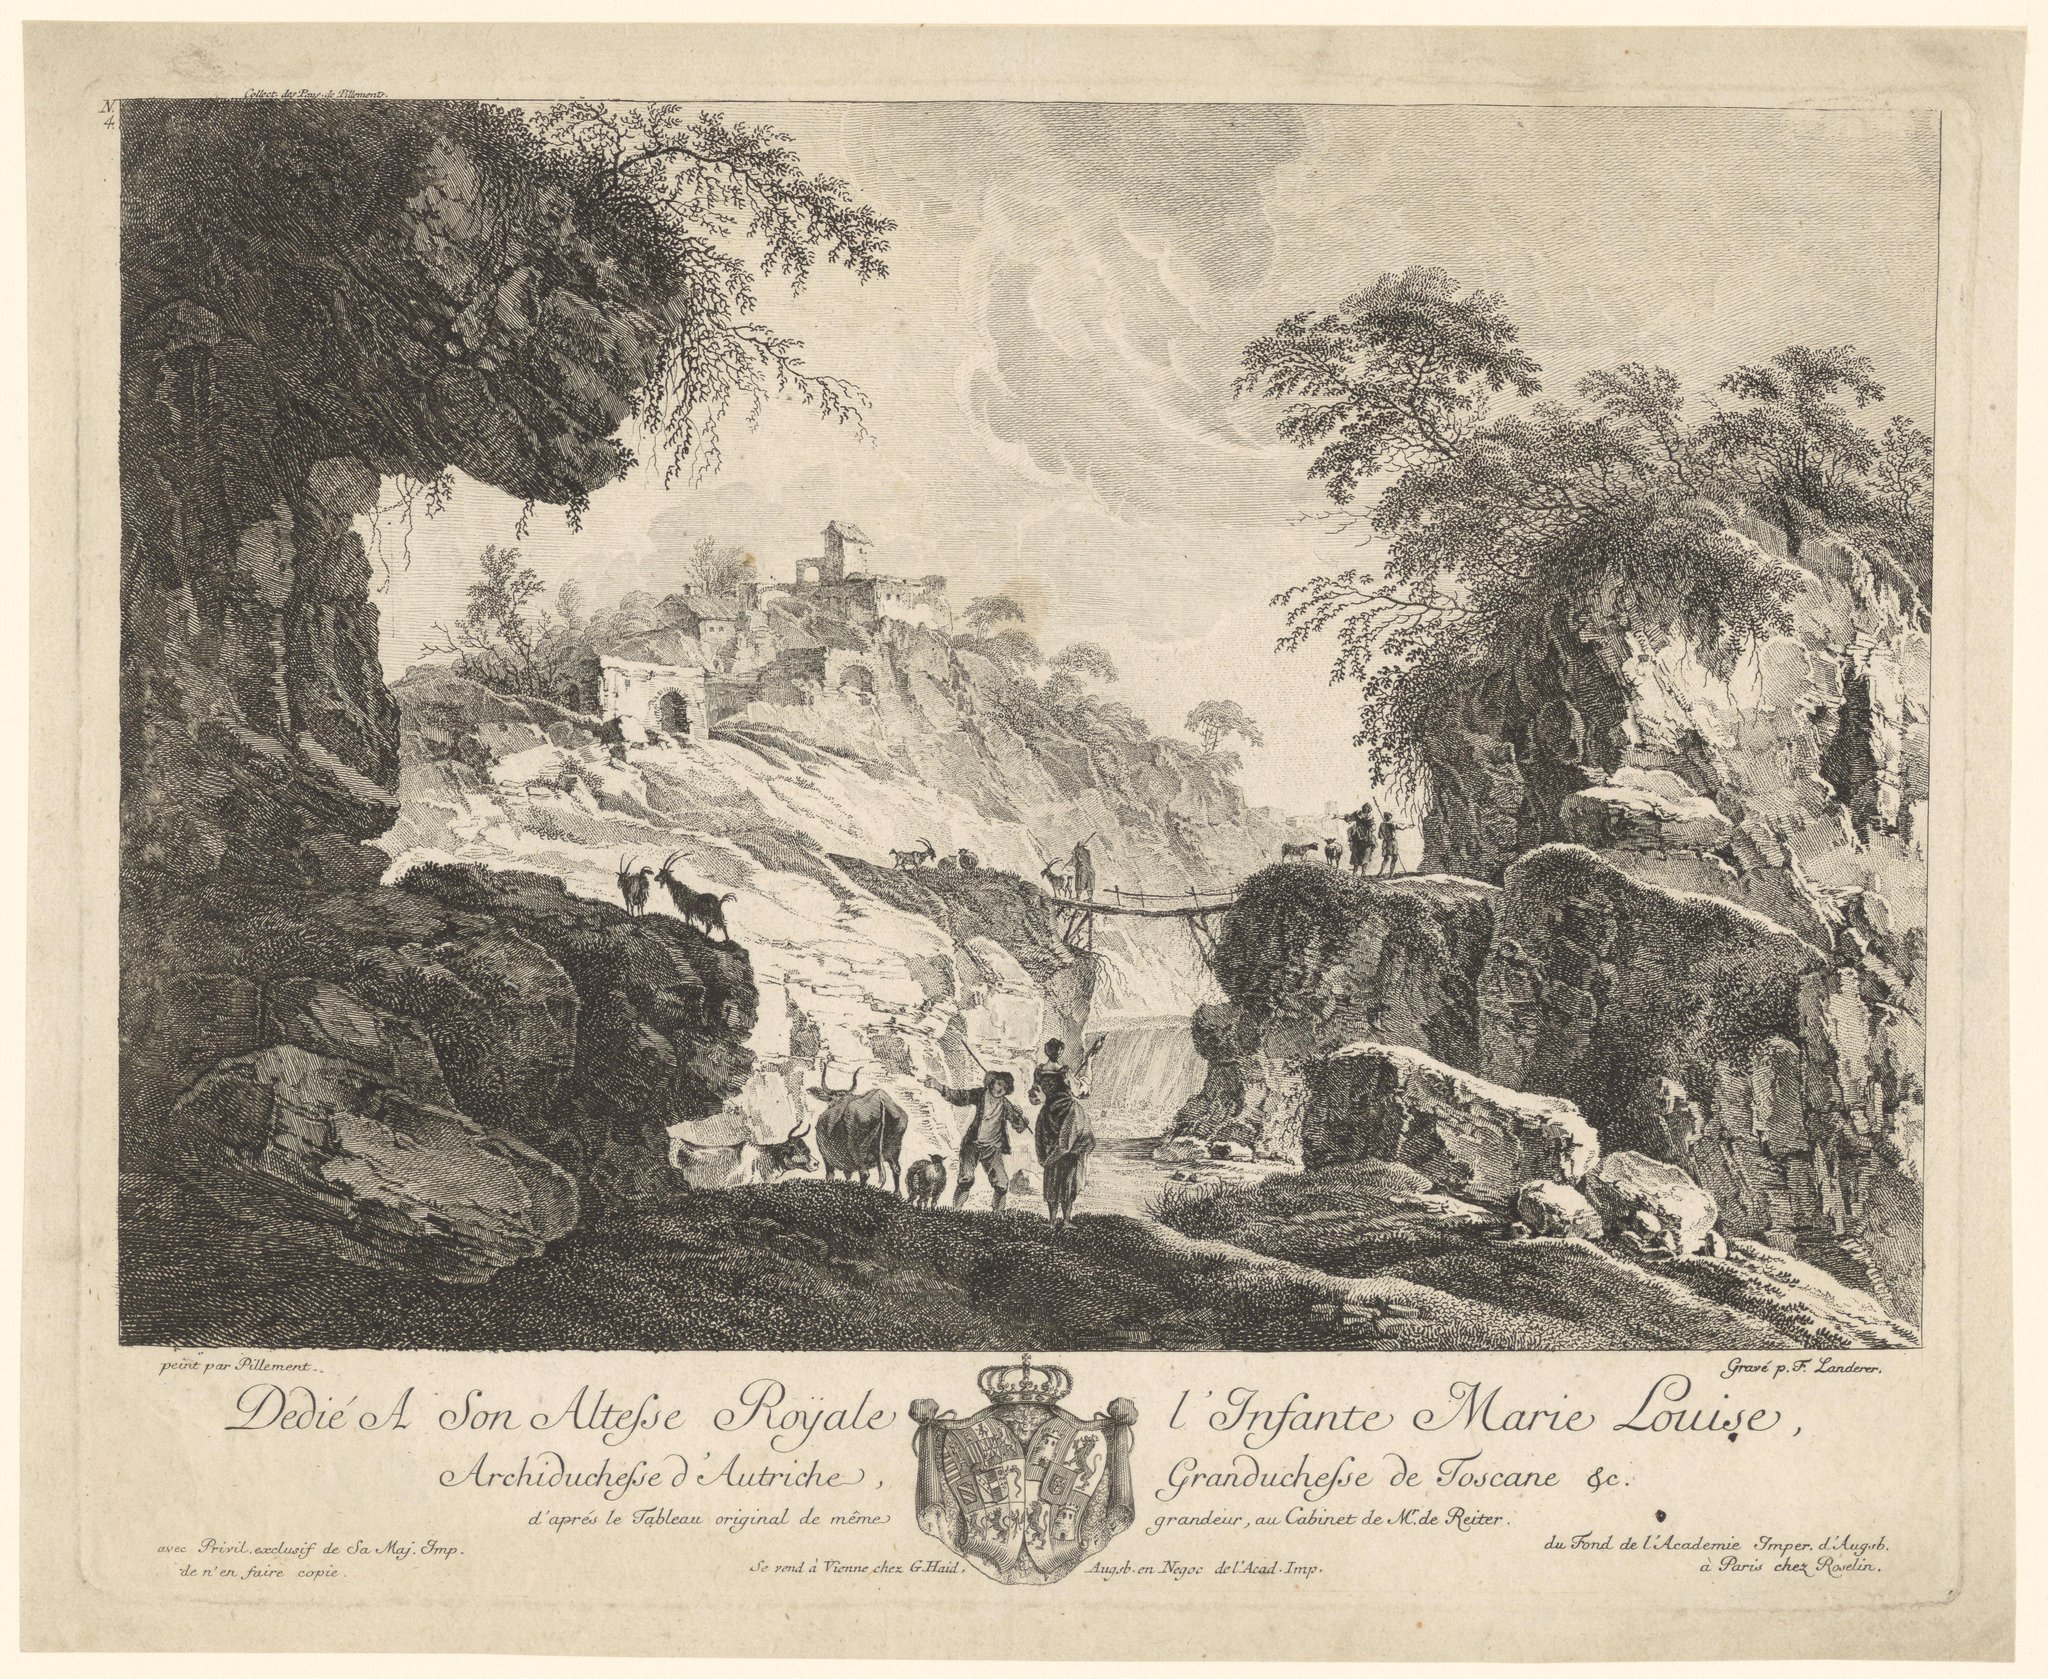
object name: print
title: Serie van landschappen naar Pillement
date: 1763-1764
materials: paper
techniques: etching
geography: vienna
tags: herding, herdsman, herdswoman, shepherd, shepherdess, cowherd, etc., waterfall, landscape with ruins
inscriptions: collector's mark: Lugt 2228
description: Deze prent maakt deel uit van een serie van acht prenten met landschappen.